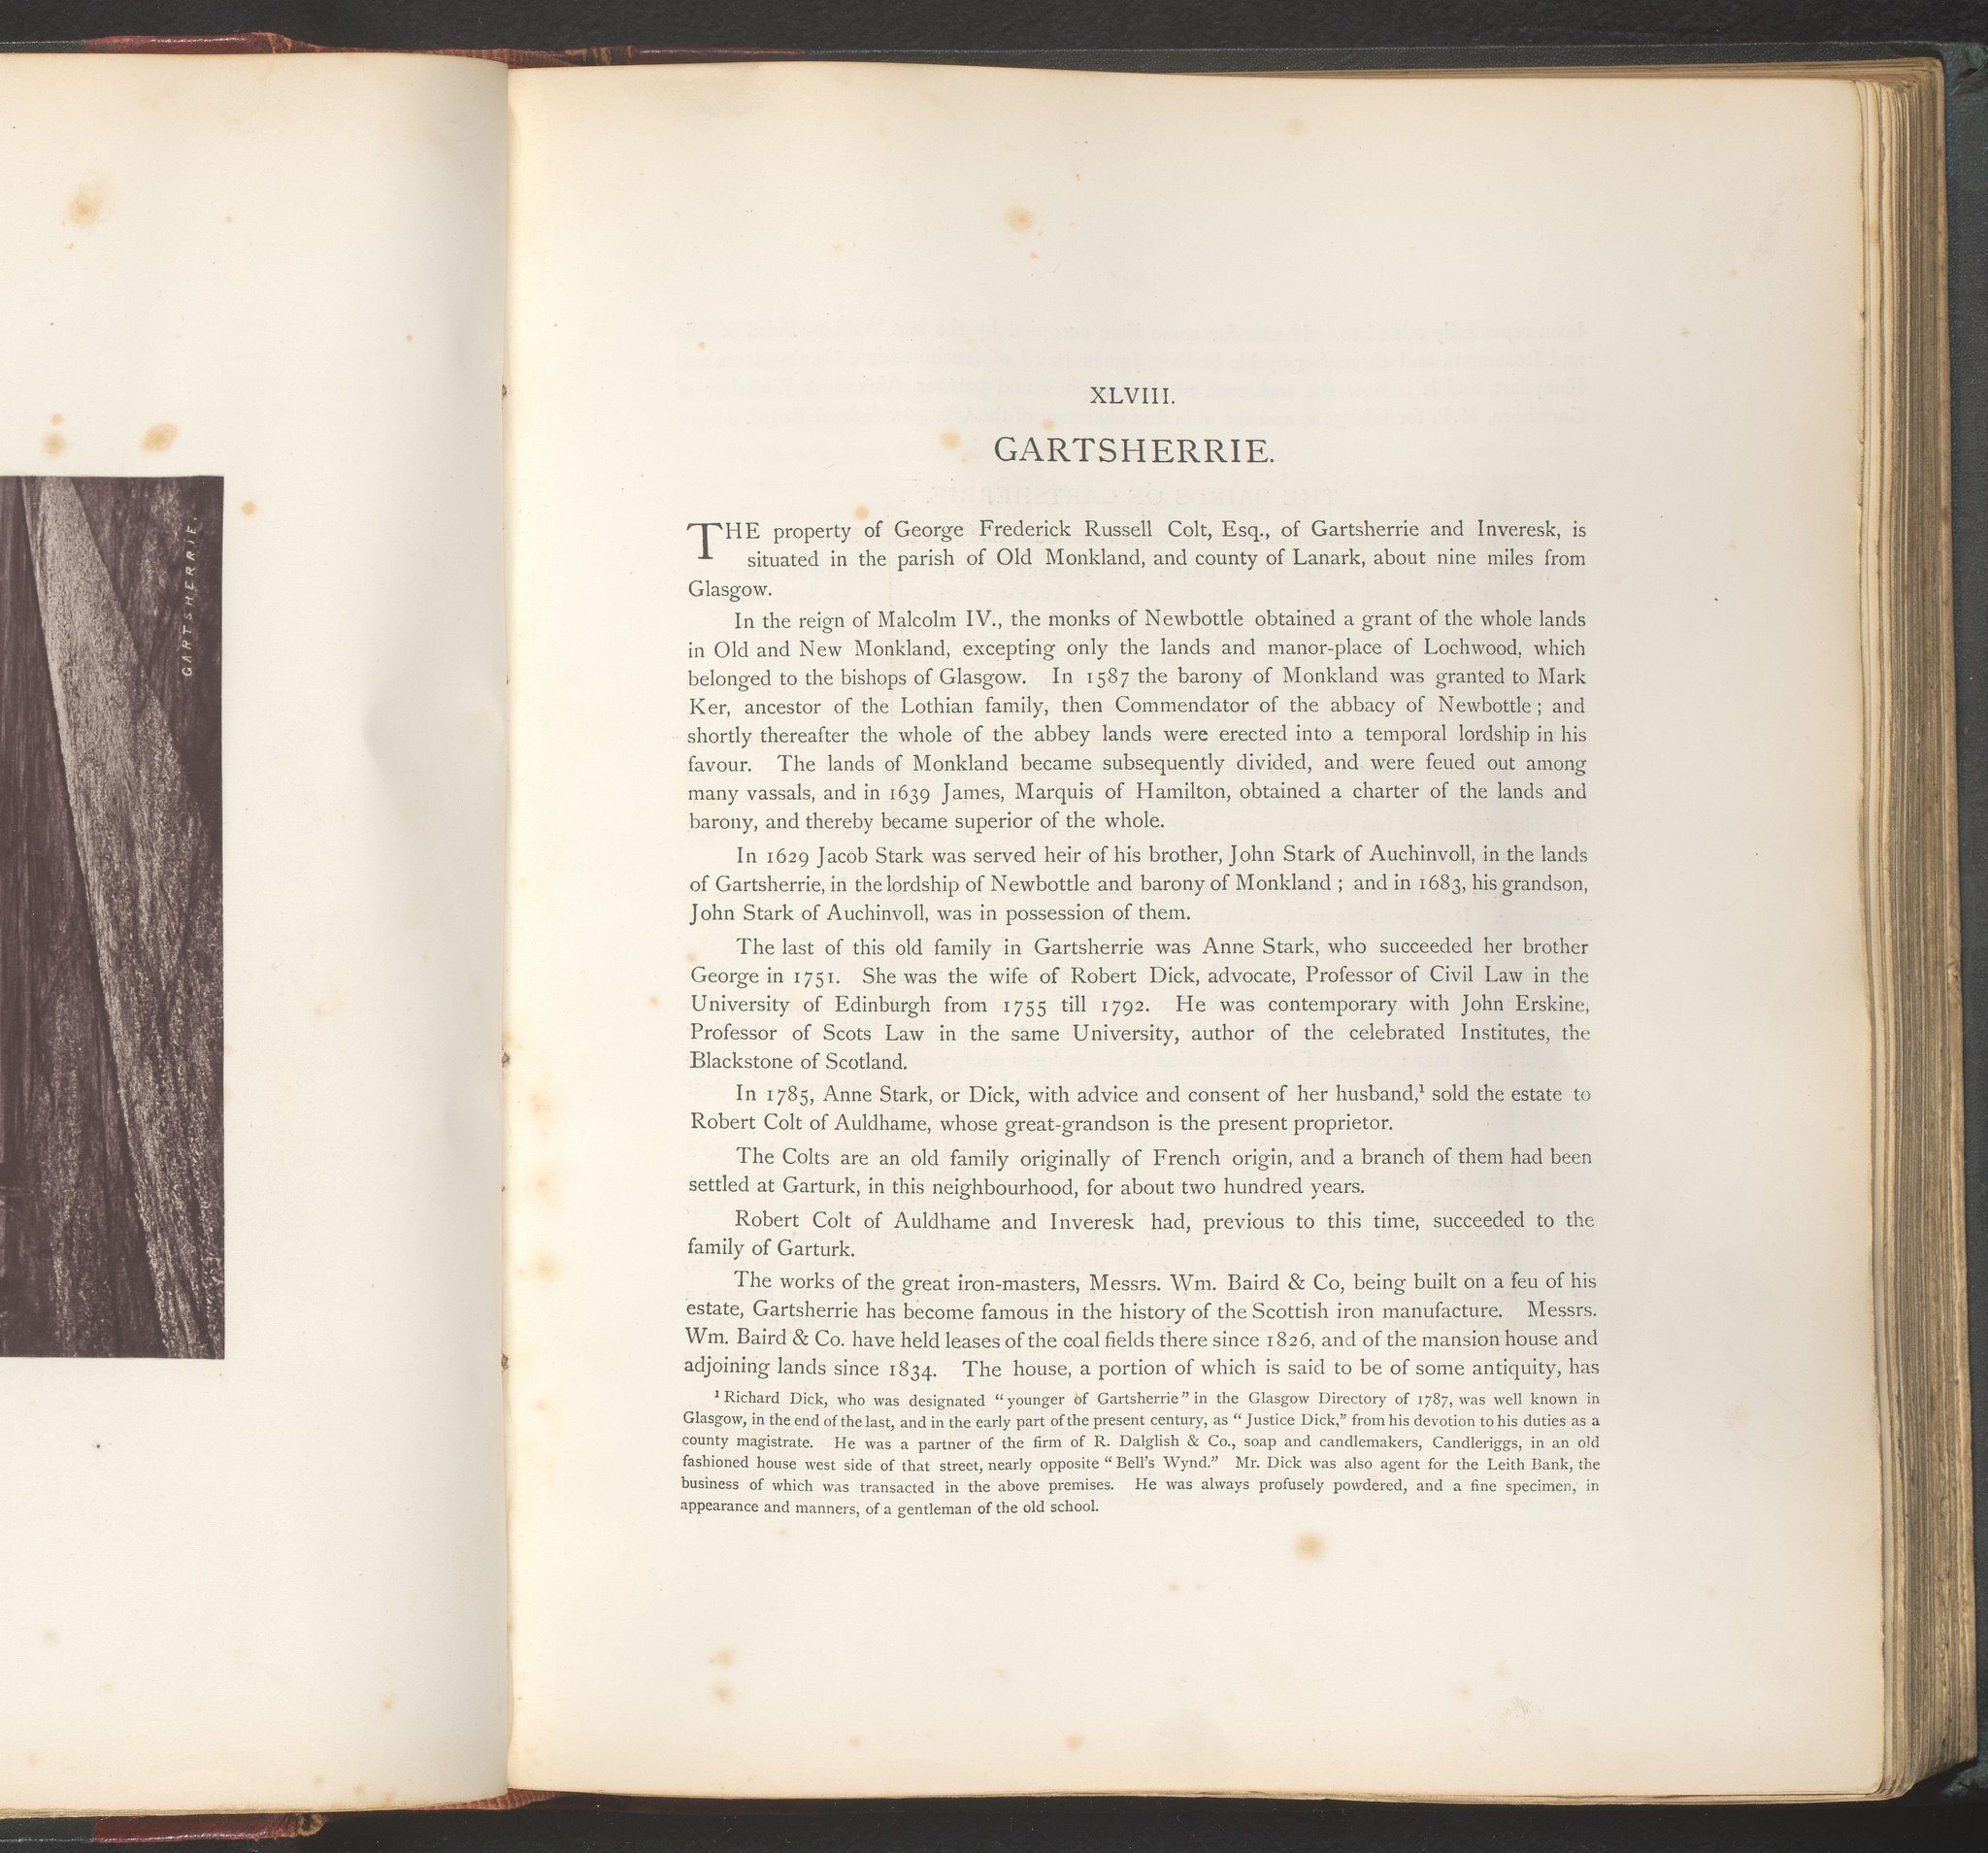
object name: photograph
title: Gartsherrie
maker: thomas annan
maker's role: fotograaf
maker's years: 1829-1887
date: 1868-1878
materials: paper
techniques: carbon print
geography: scotland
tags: rural housing, e.g. country-house, villa, cottage, façade (of house or building)